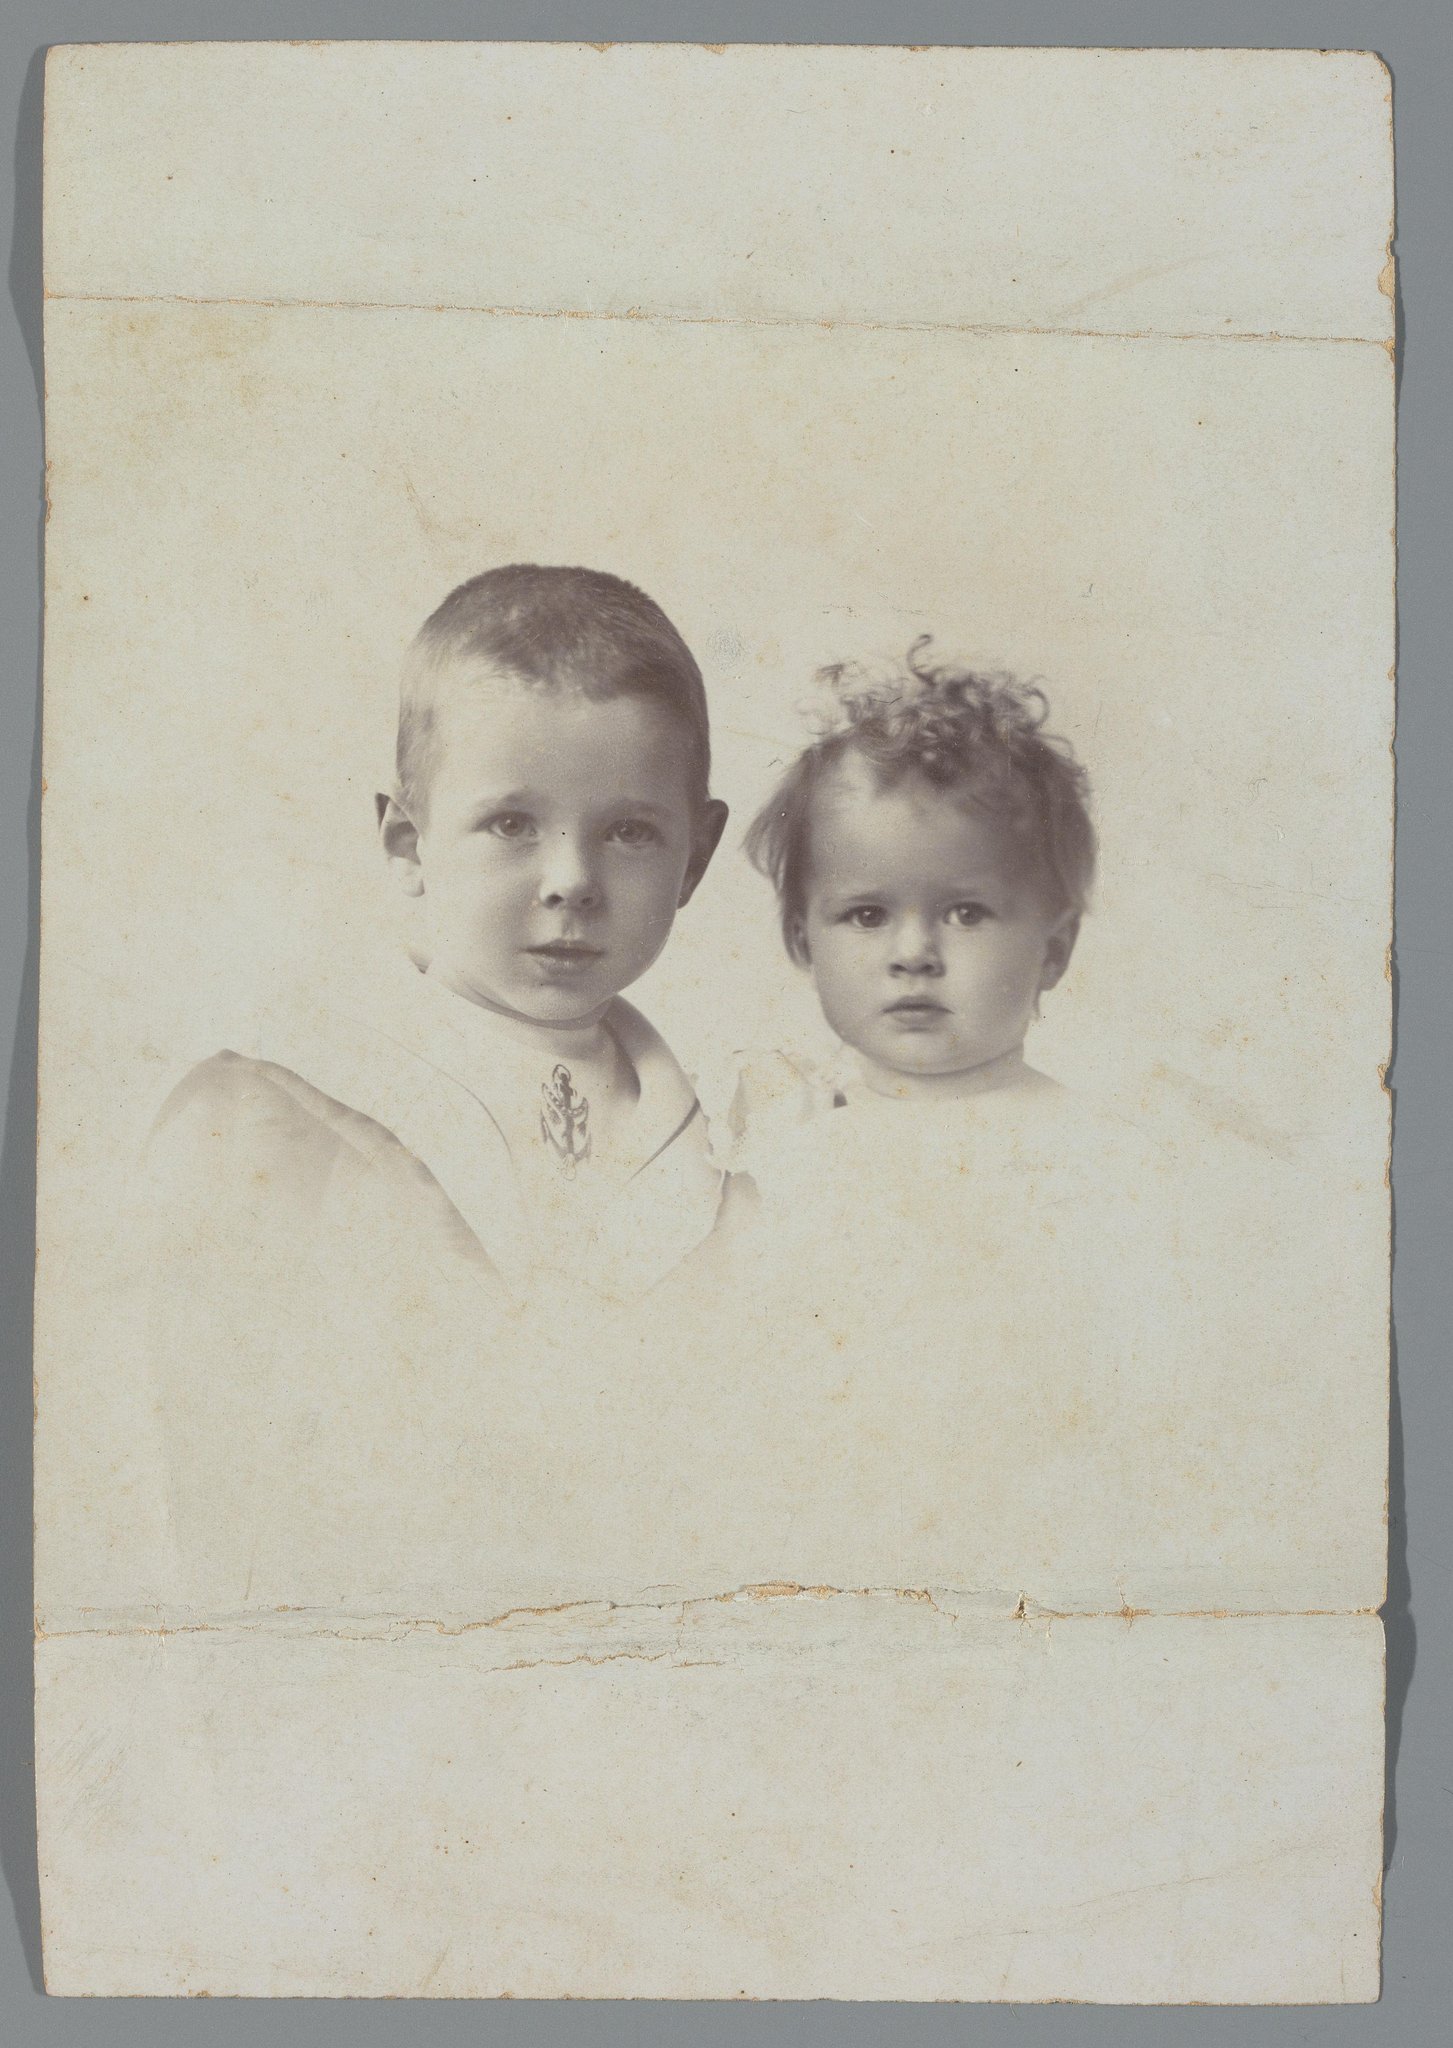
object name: photograph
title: Studioportret van twee kinderen van Emilie van den Berg en Piet Onnen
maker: Anonymous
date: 1890-1920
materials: photographic support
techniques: albumen print